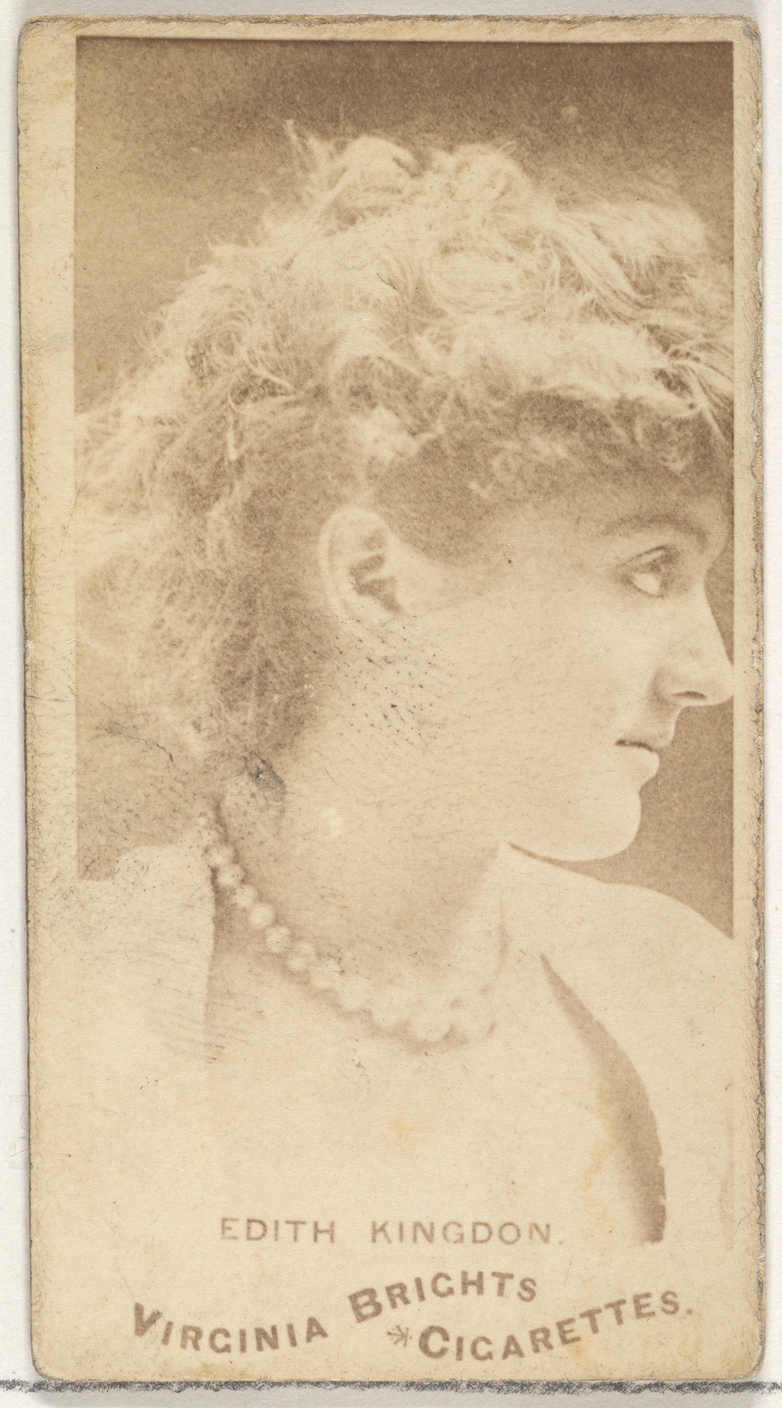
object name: photograph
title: Edith Kingdon, from the Actors and Actresses series (N45, Type 1) for Virginia Brights Cigarettes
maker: allen & ginter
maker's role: publisher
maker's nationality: american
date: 1888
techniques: albumen silver print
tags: portraits,profiles,women,actresses